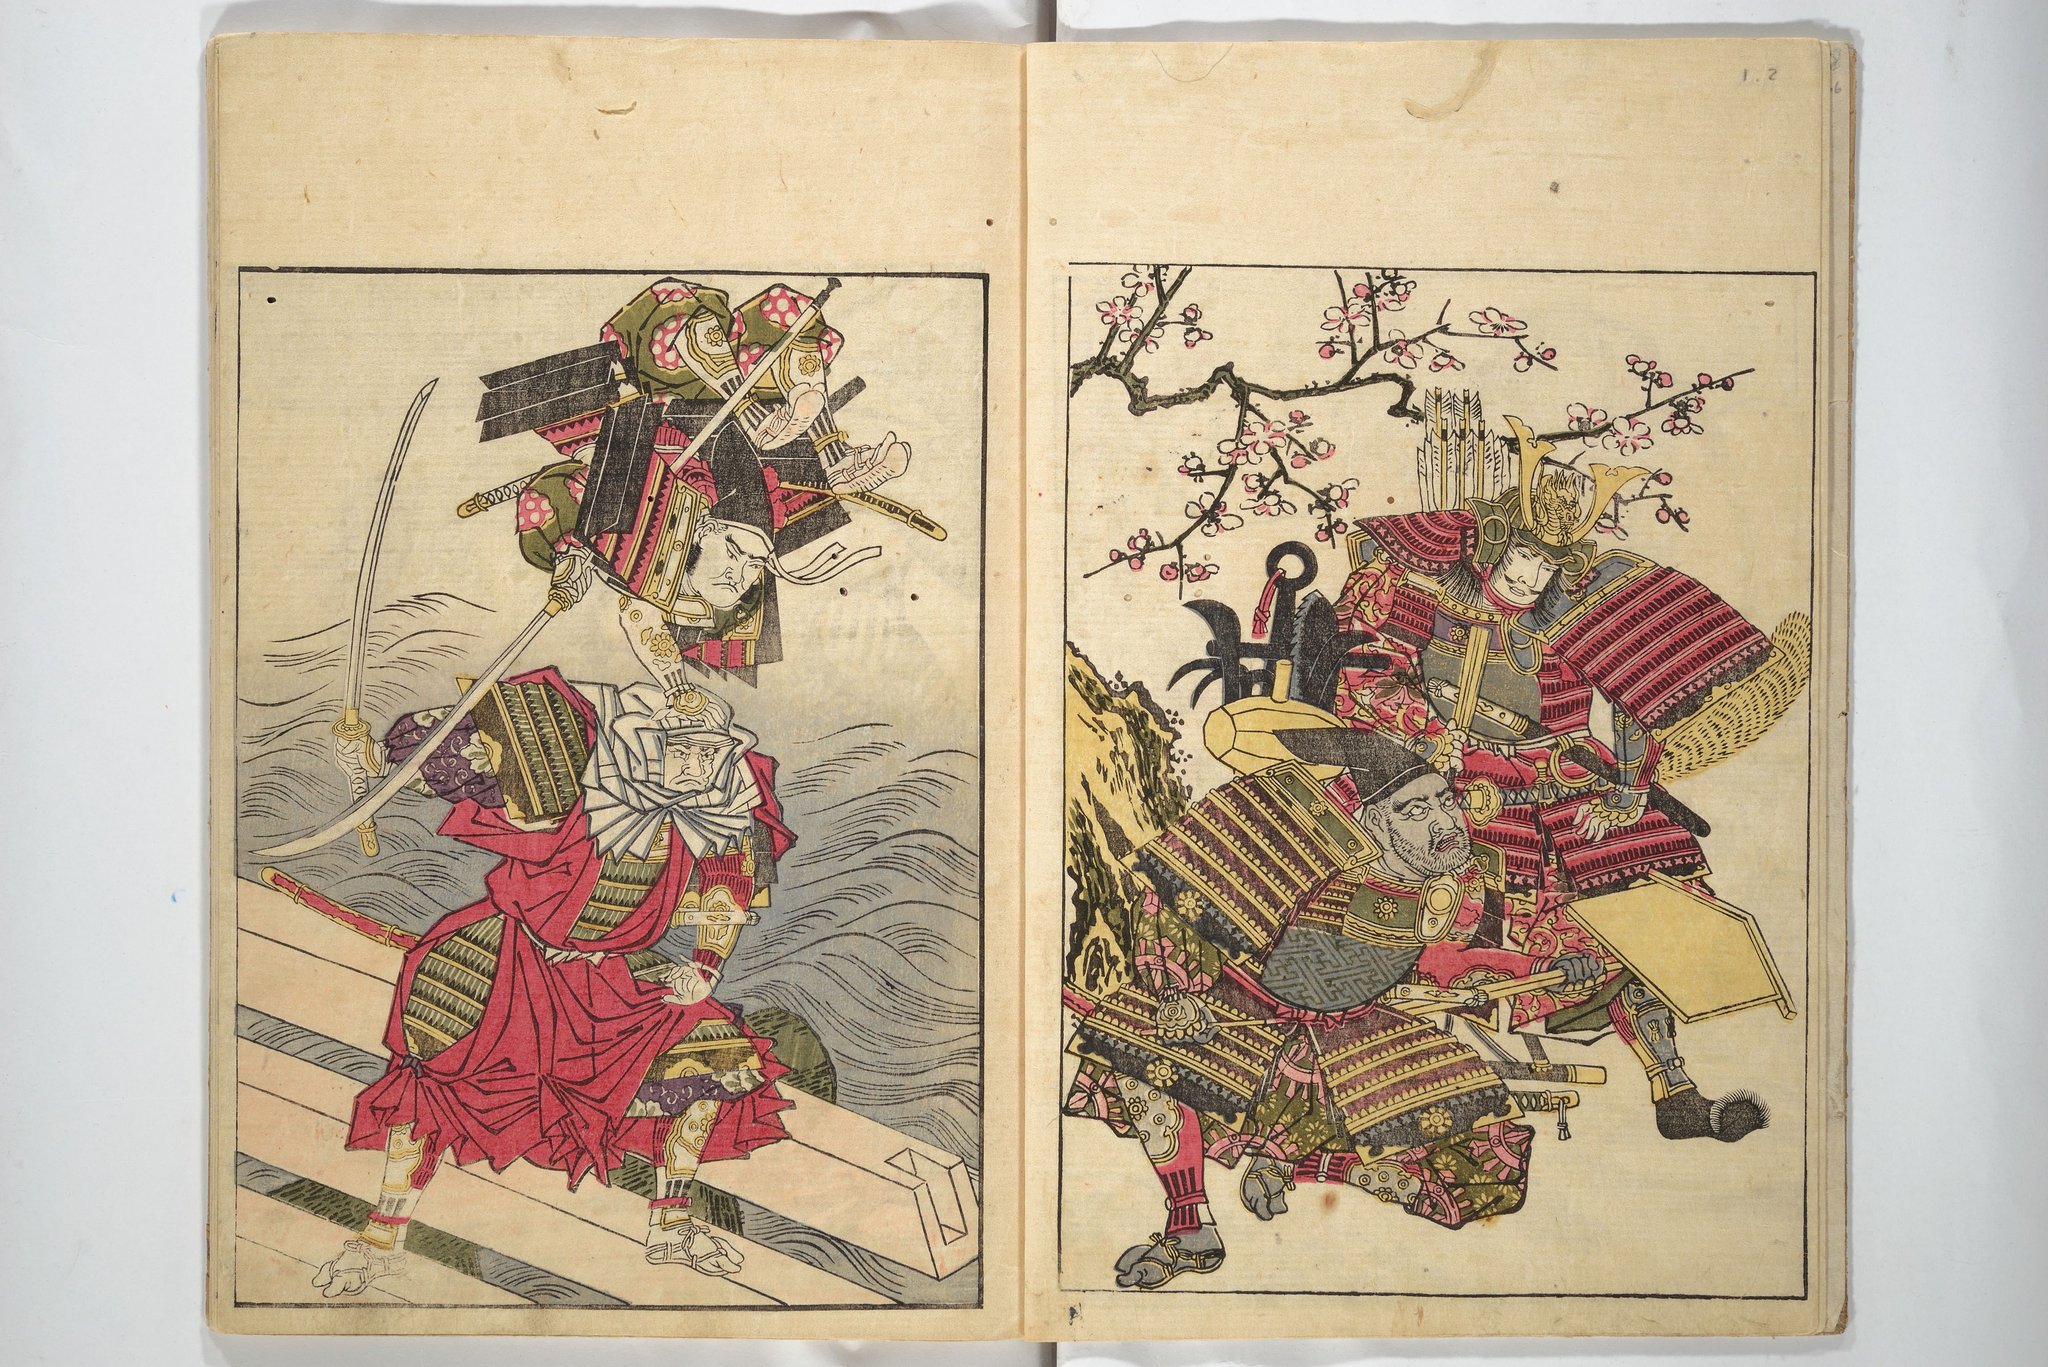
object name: illustrated book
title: Picture Book of the Warriors' Sandals (Ehon musha waraji) 絵本武者鞋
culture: japanese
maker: kitao shigemasa 北尾重政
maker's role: artist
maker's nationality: japanese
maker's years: 1739-1820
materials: ink, paper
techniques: woodblock print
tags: soldiers,swords,men